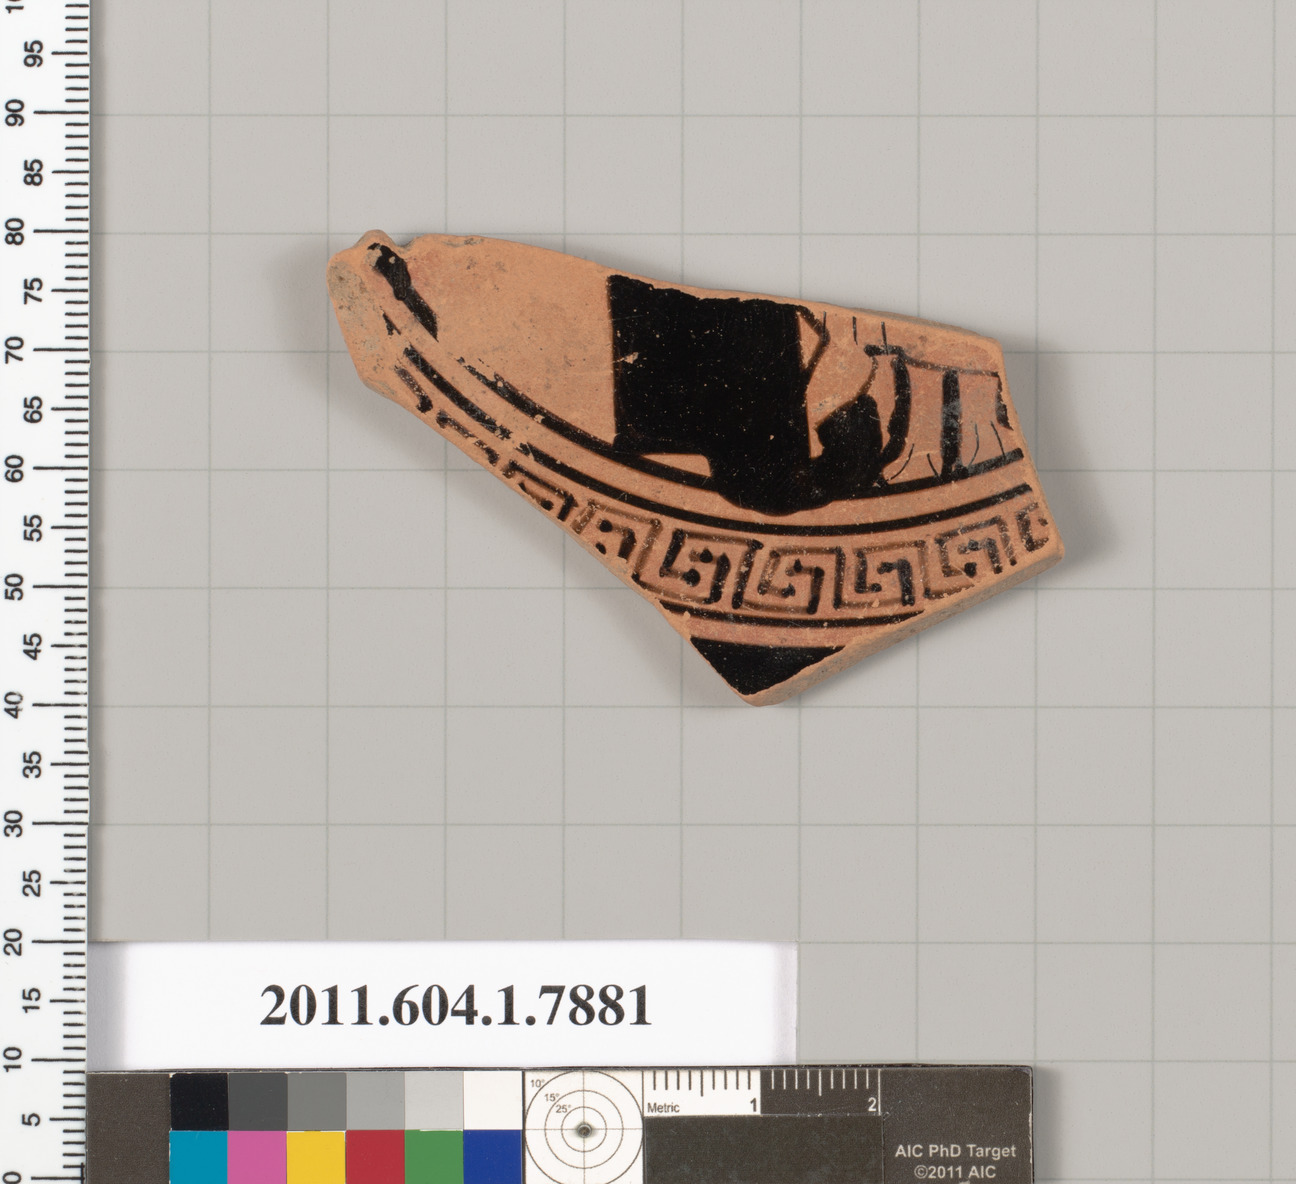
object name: kylix fragment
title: Terracotta fragment of a kylix (drinking cup)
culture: greek, attic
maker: veii painter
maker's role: artist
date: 460-450 BCE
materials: terracotta